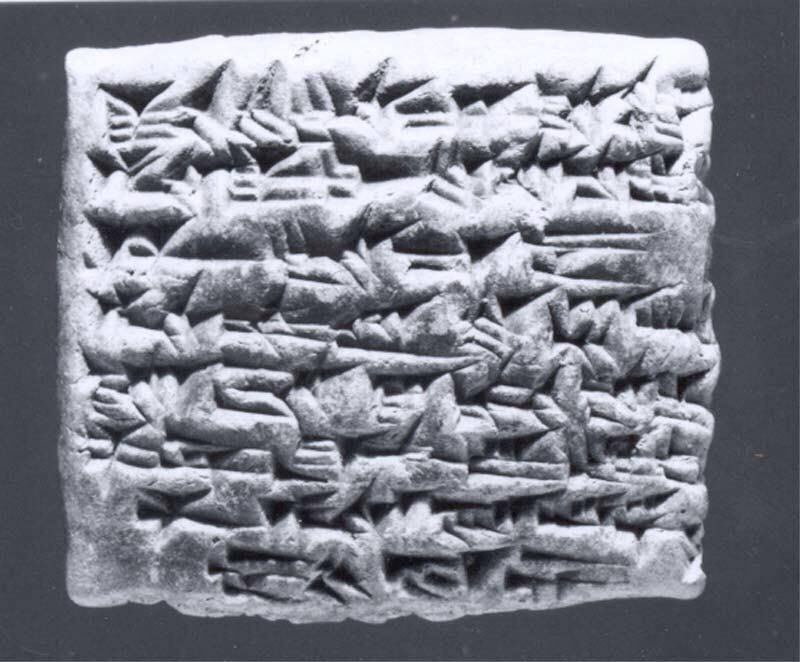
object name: cuneiform tablet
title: Cuneiform tablet: record of barley allocations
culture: assyrian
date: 1300-1201 BCE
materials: clay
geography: mesopotamia